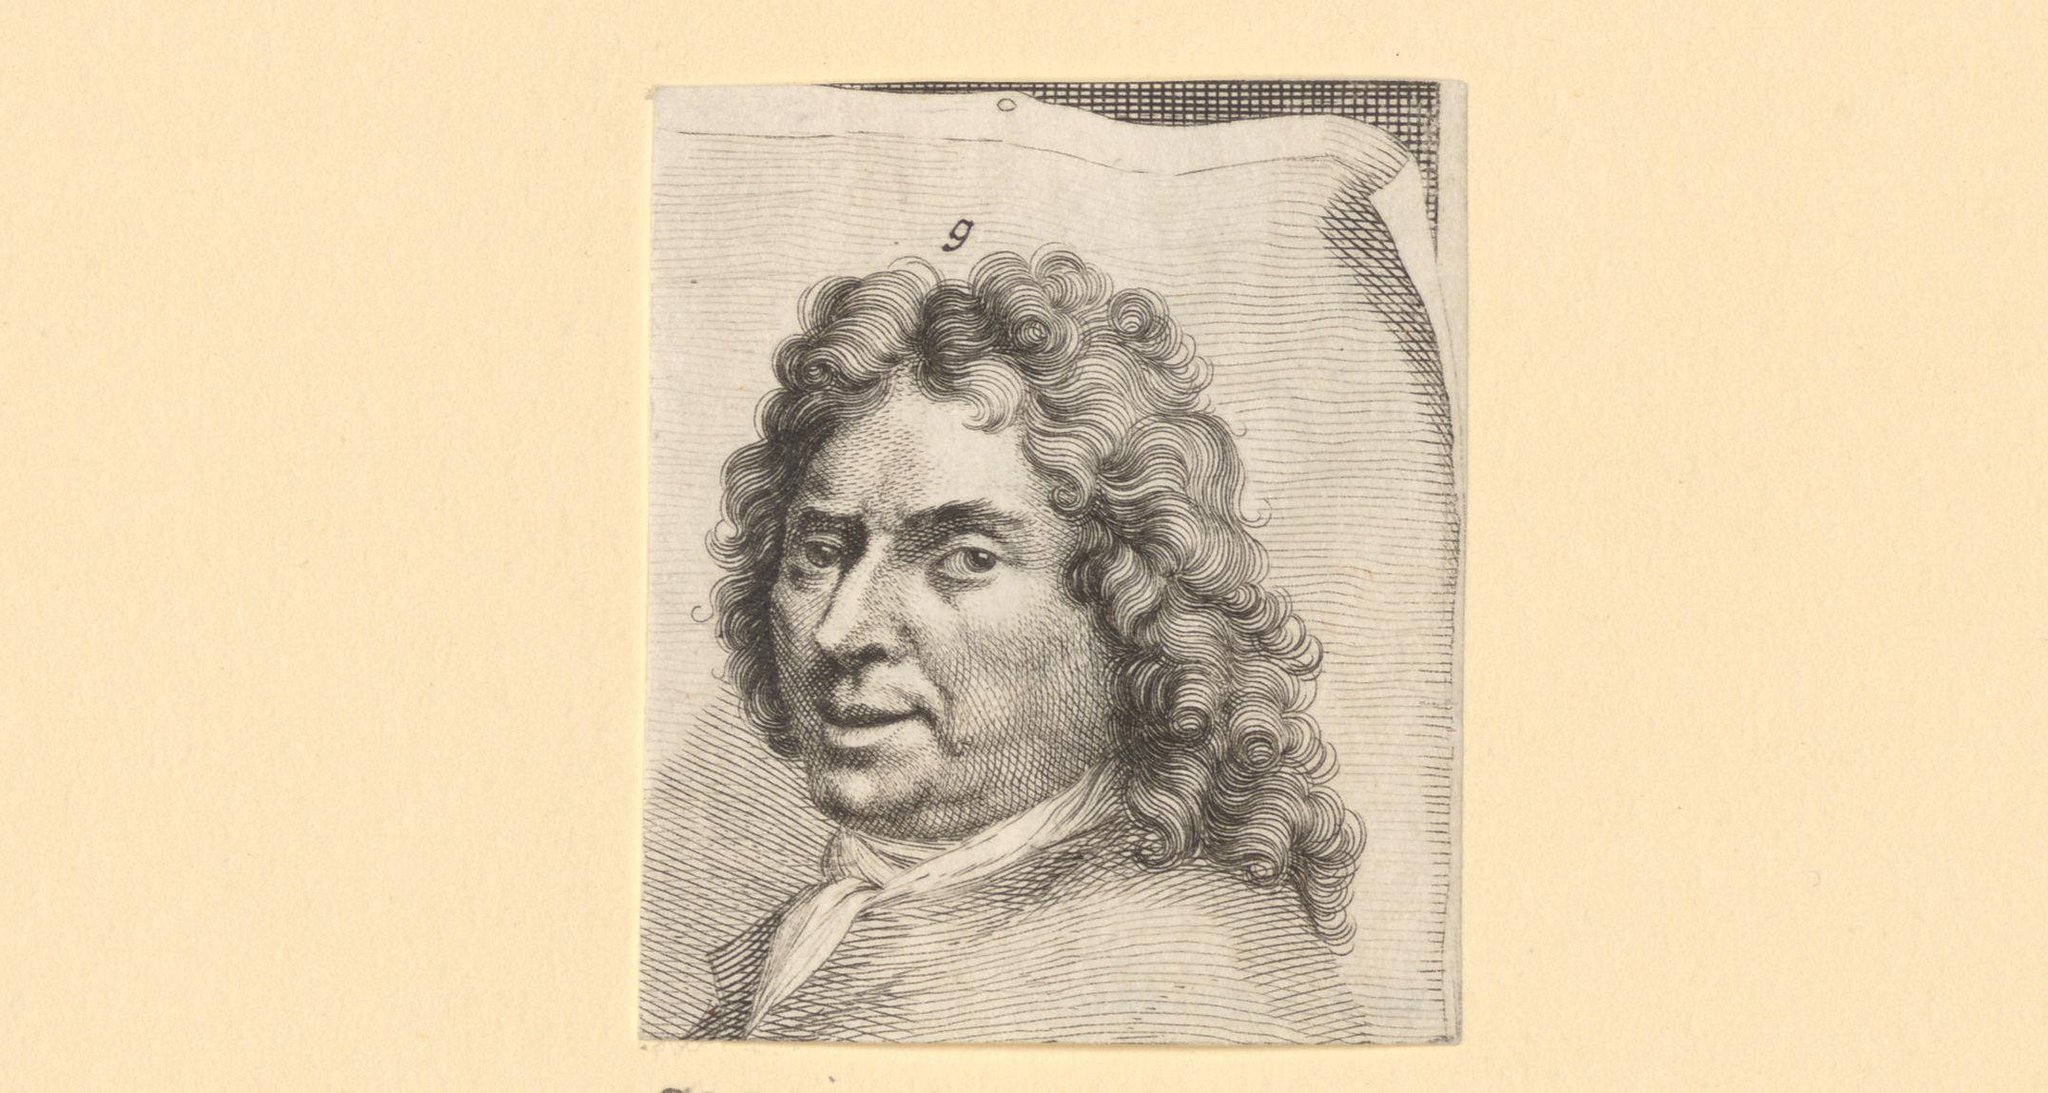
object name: print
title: Portret van Jan van Pee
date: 1721-1729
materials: paper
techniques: engraving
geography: the hague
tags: antwerp, jan van pee, adult man, historical persons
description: Geknipt van prent met de portretten van Jan Asselijn, Heyman Dullaert, Jan van Pee en Melchior de Hondecoeter (zie RP-P-1940-473). Van die prent zijn in ieder geval drie staten bekend. Het is onduidelijk of dit object van de eerste of tweede bekende staat is geknipt. De eerste staat is gebruikt in: Houbraken, Arnold. De groote schouburgh der Nederlantsche konstschilders en schilderessen (...). 3 dln. Amsterdam: weduwe Arnold Houbraken [Sara Sasbout Souburgh], 1721, dl. 3. De tweede in: Weyerman, Jacob Campo. De levens-beschryvingen der Nederlandsche konst-schilders en konst-schilderessen (...). 4 dln. Den Haag: weduwe Engelbrecht Boucquet, Frederik Bouquet, Hendrik Scheurleer en Jacobus de Jongh, 1729, dl. 2. De derde in: Houbraken, Arnold. De groote schouburgh der Nederlantsche konstschilders en schilderessen (...). 3 dln. Den Haag: Johannes Swart, Mattheus Gaillard en Cornelis Boucquet, 1753, dl. 3.